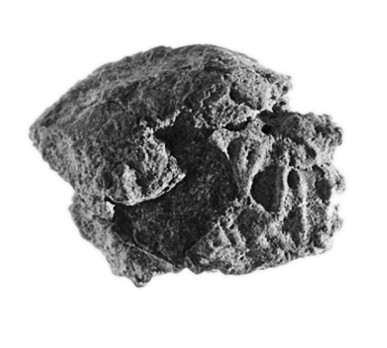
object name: sealing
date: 1981-1640 BCE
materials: mud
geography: egypt